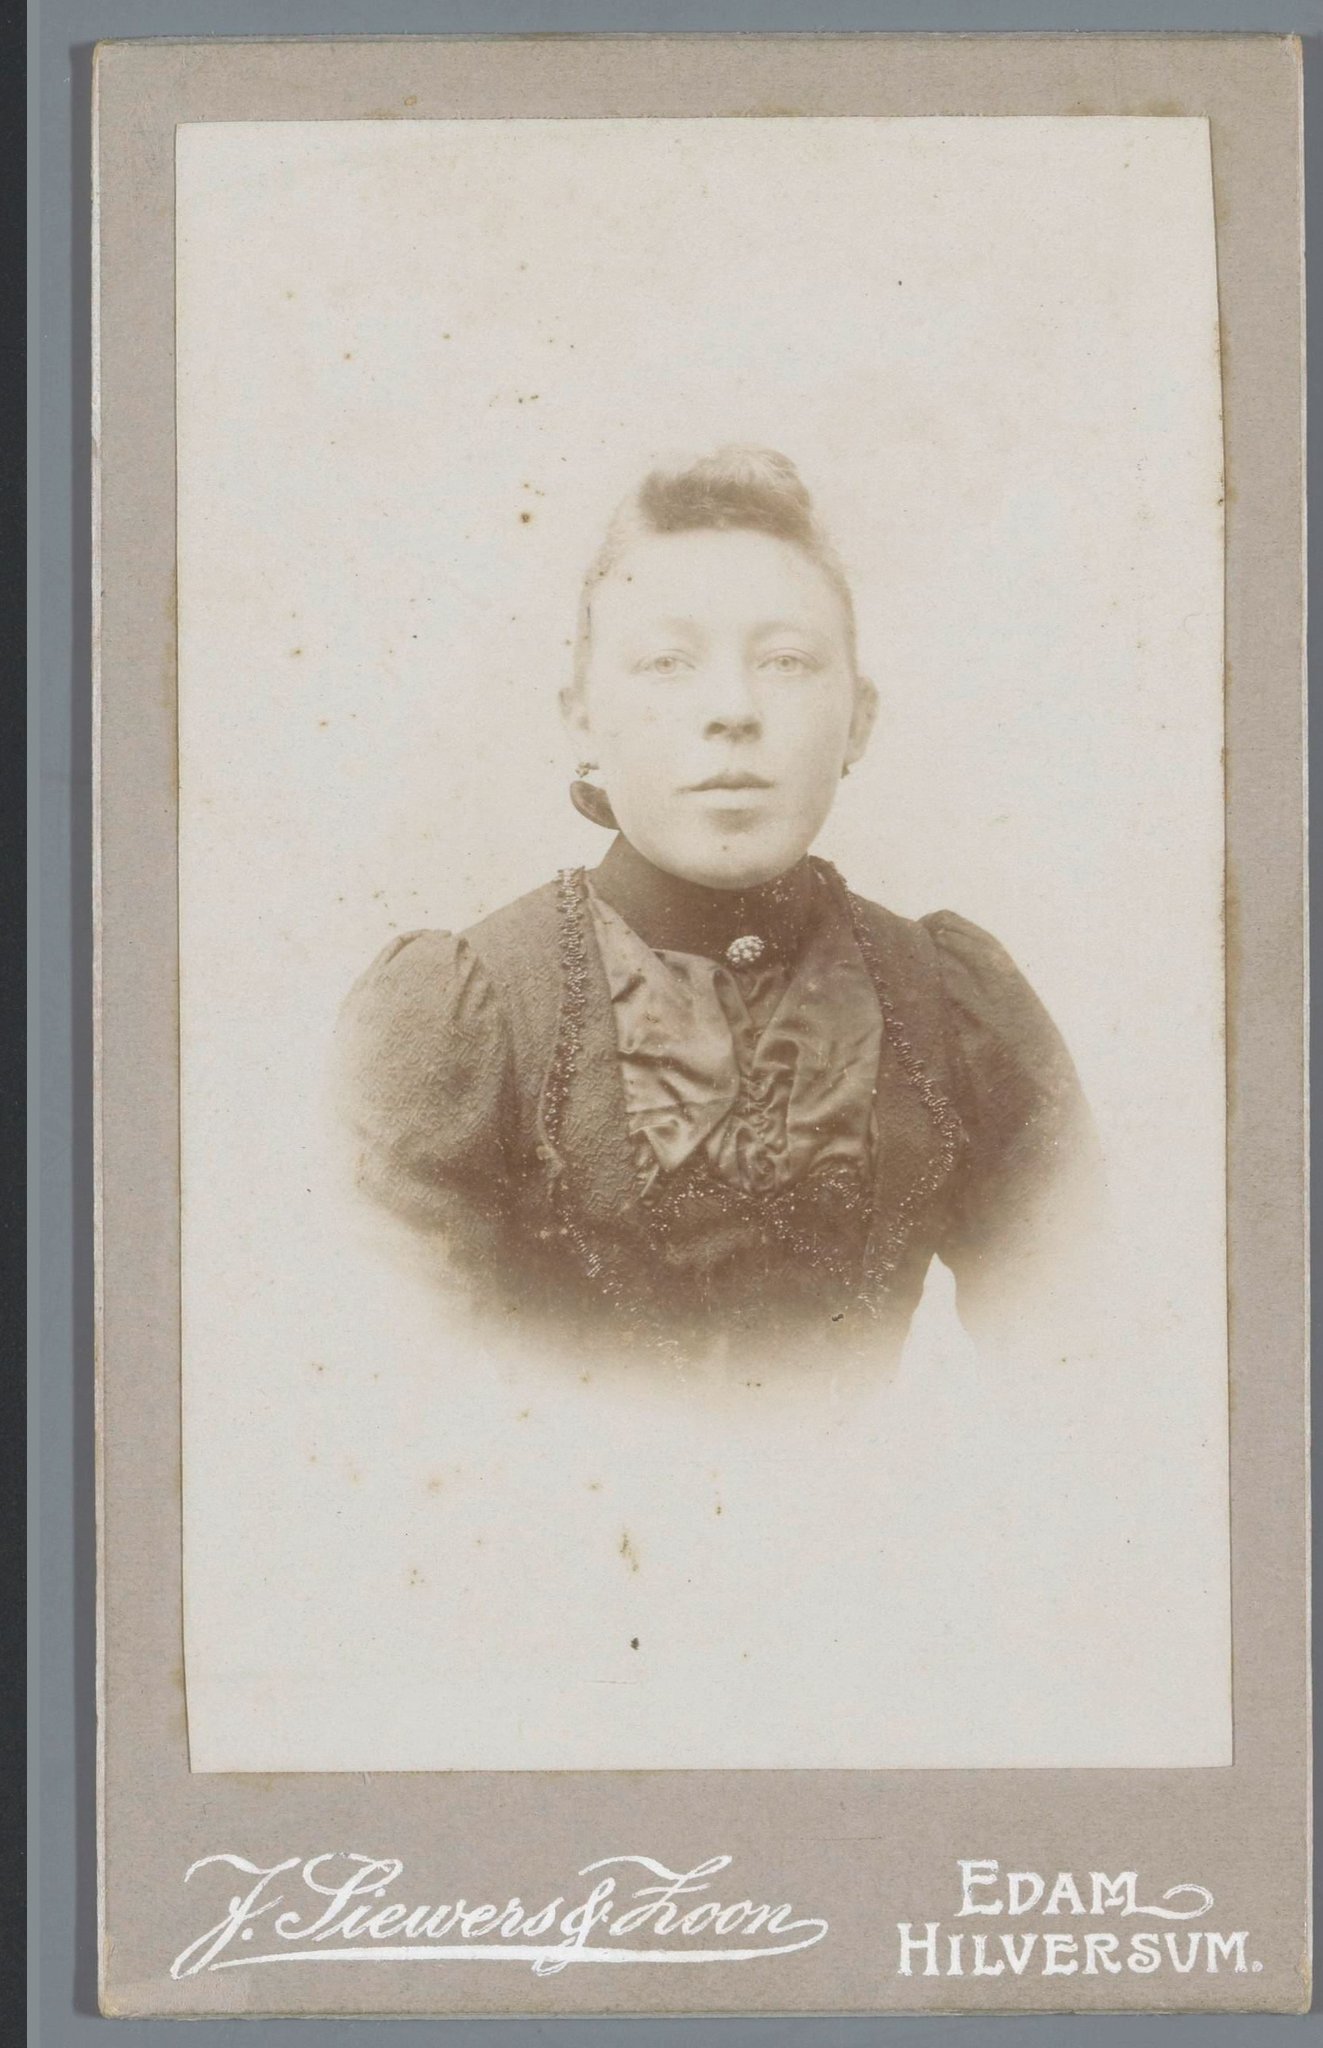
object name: photograph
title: Portret van een onbekende vrouw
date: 1890-1918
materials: cardboard, photographic support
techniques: collodion silver print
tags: historical persons - bb - woman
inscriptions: inscription: ‘Photographische/ ATELIERS/ J. Siewers & Zoon/ EDAM/ HILVERSUM./ Specialiteit in vergrootingen.’